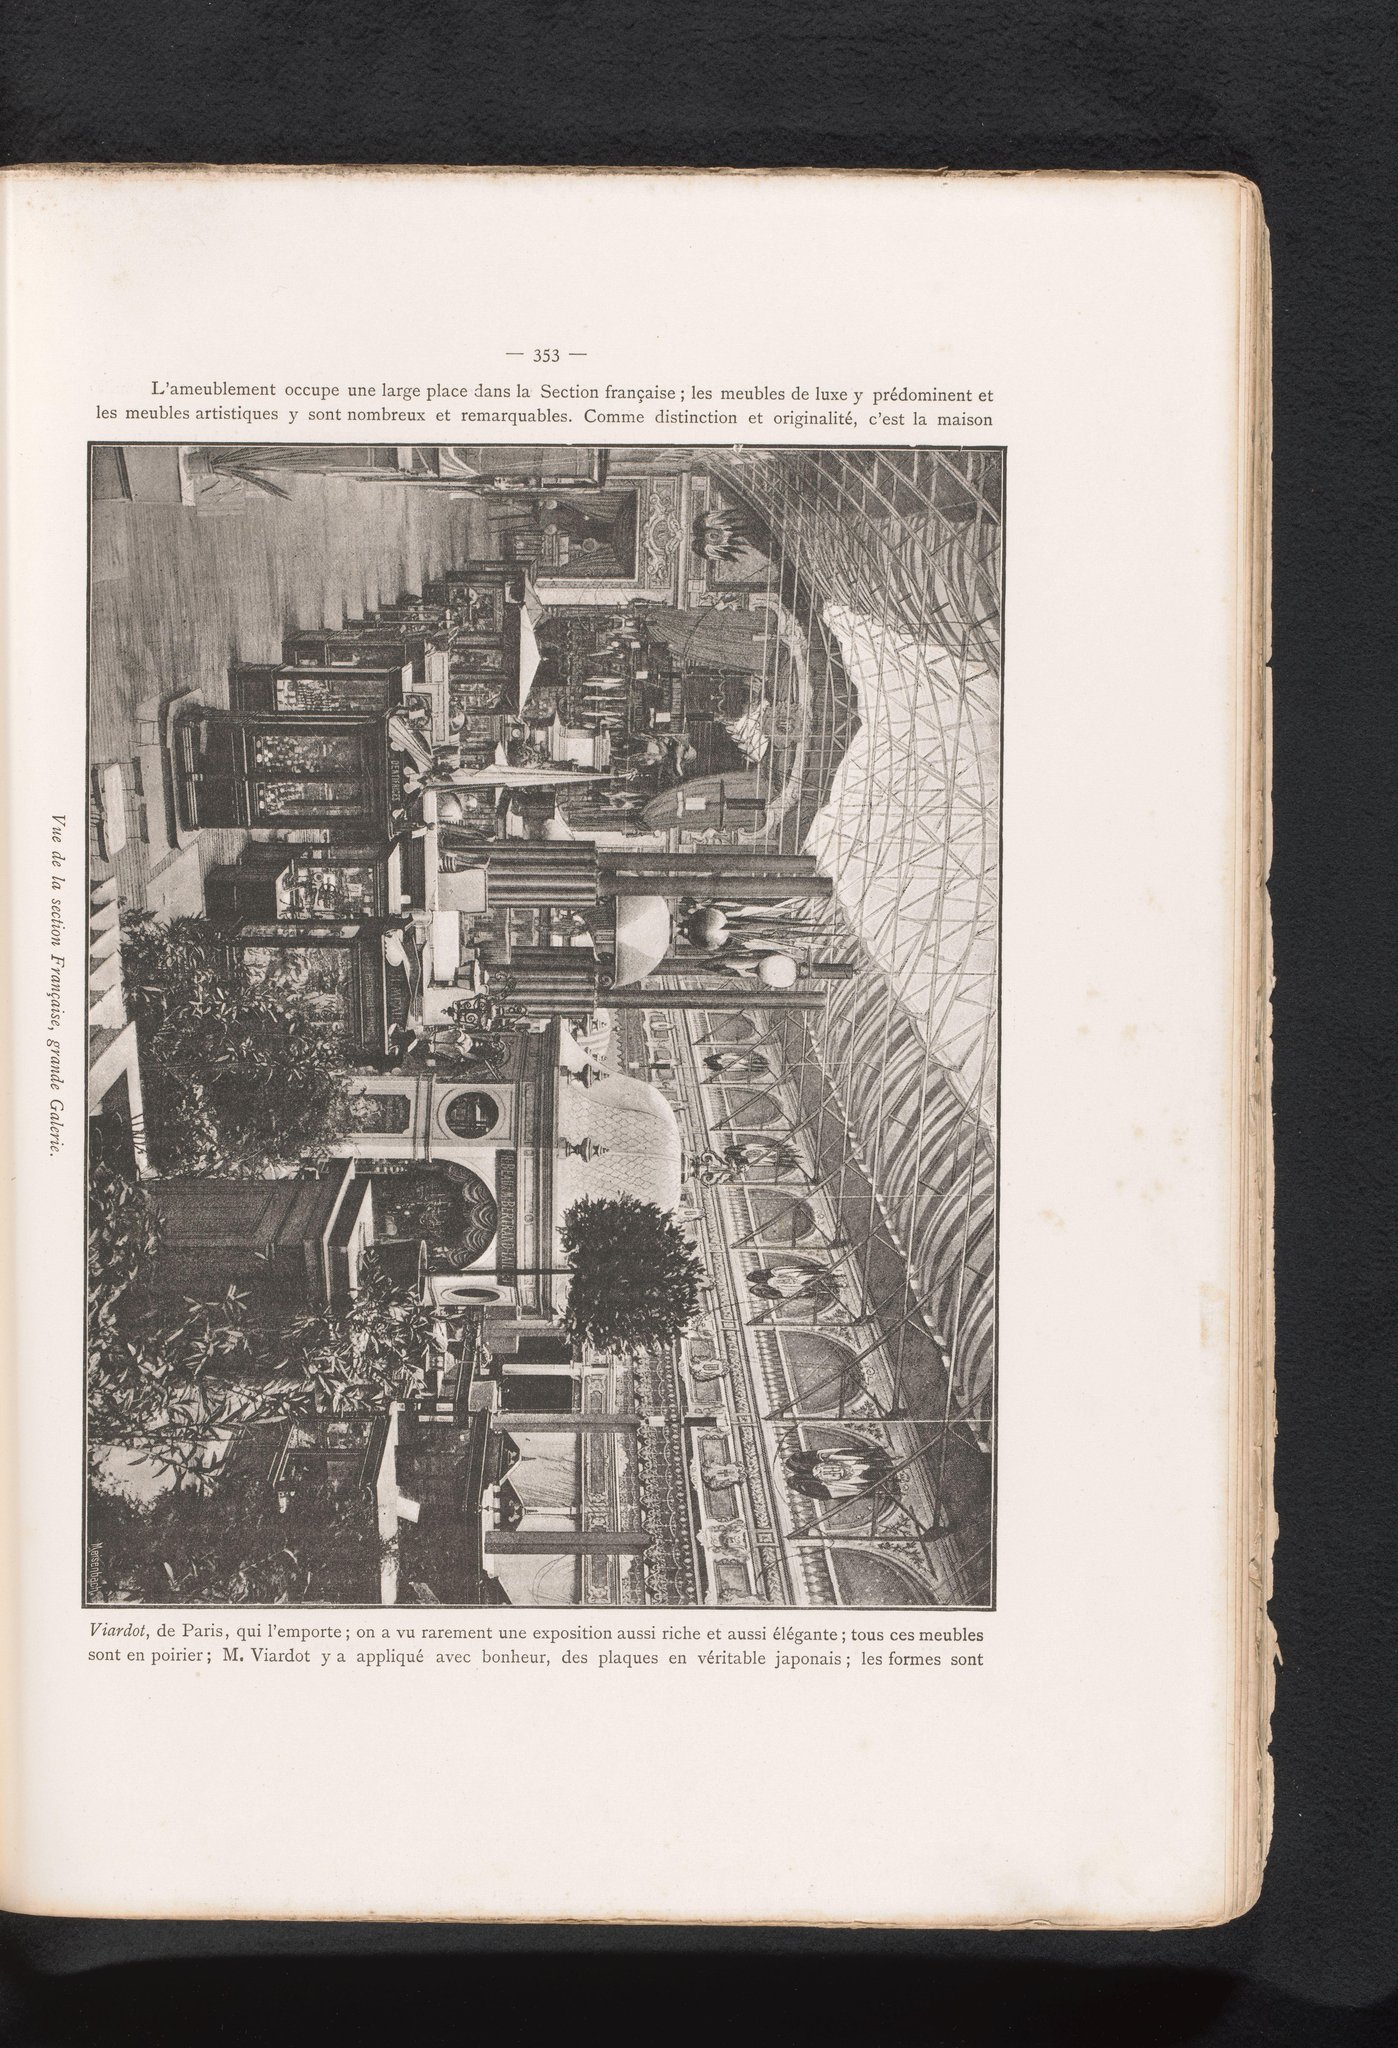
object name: photomechanical print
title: Gezicht op de galerij van het Franse deel van de Wereldtentoonstelling van 1885 in Antwerpen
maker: Anonymous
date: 1880-1885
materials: paper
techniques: autotype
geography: antwerp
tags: world fair, world exhibition, antwerp